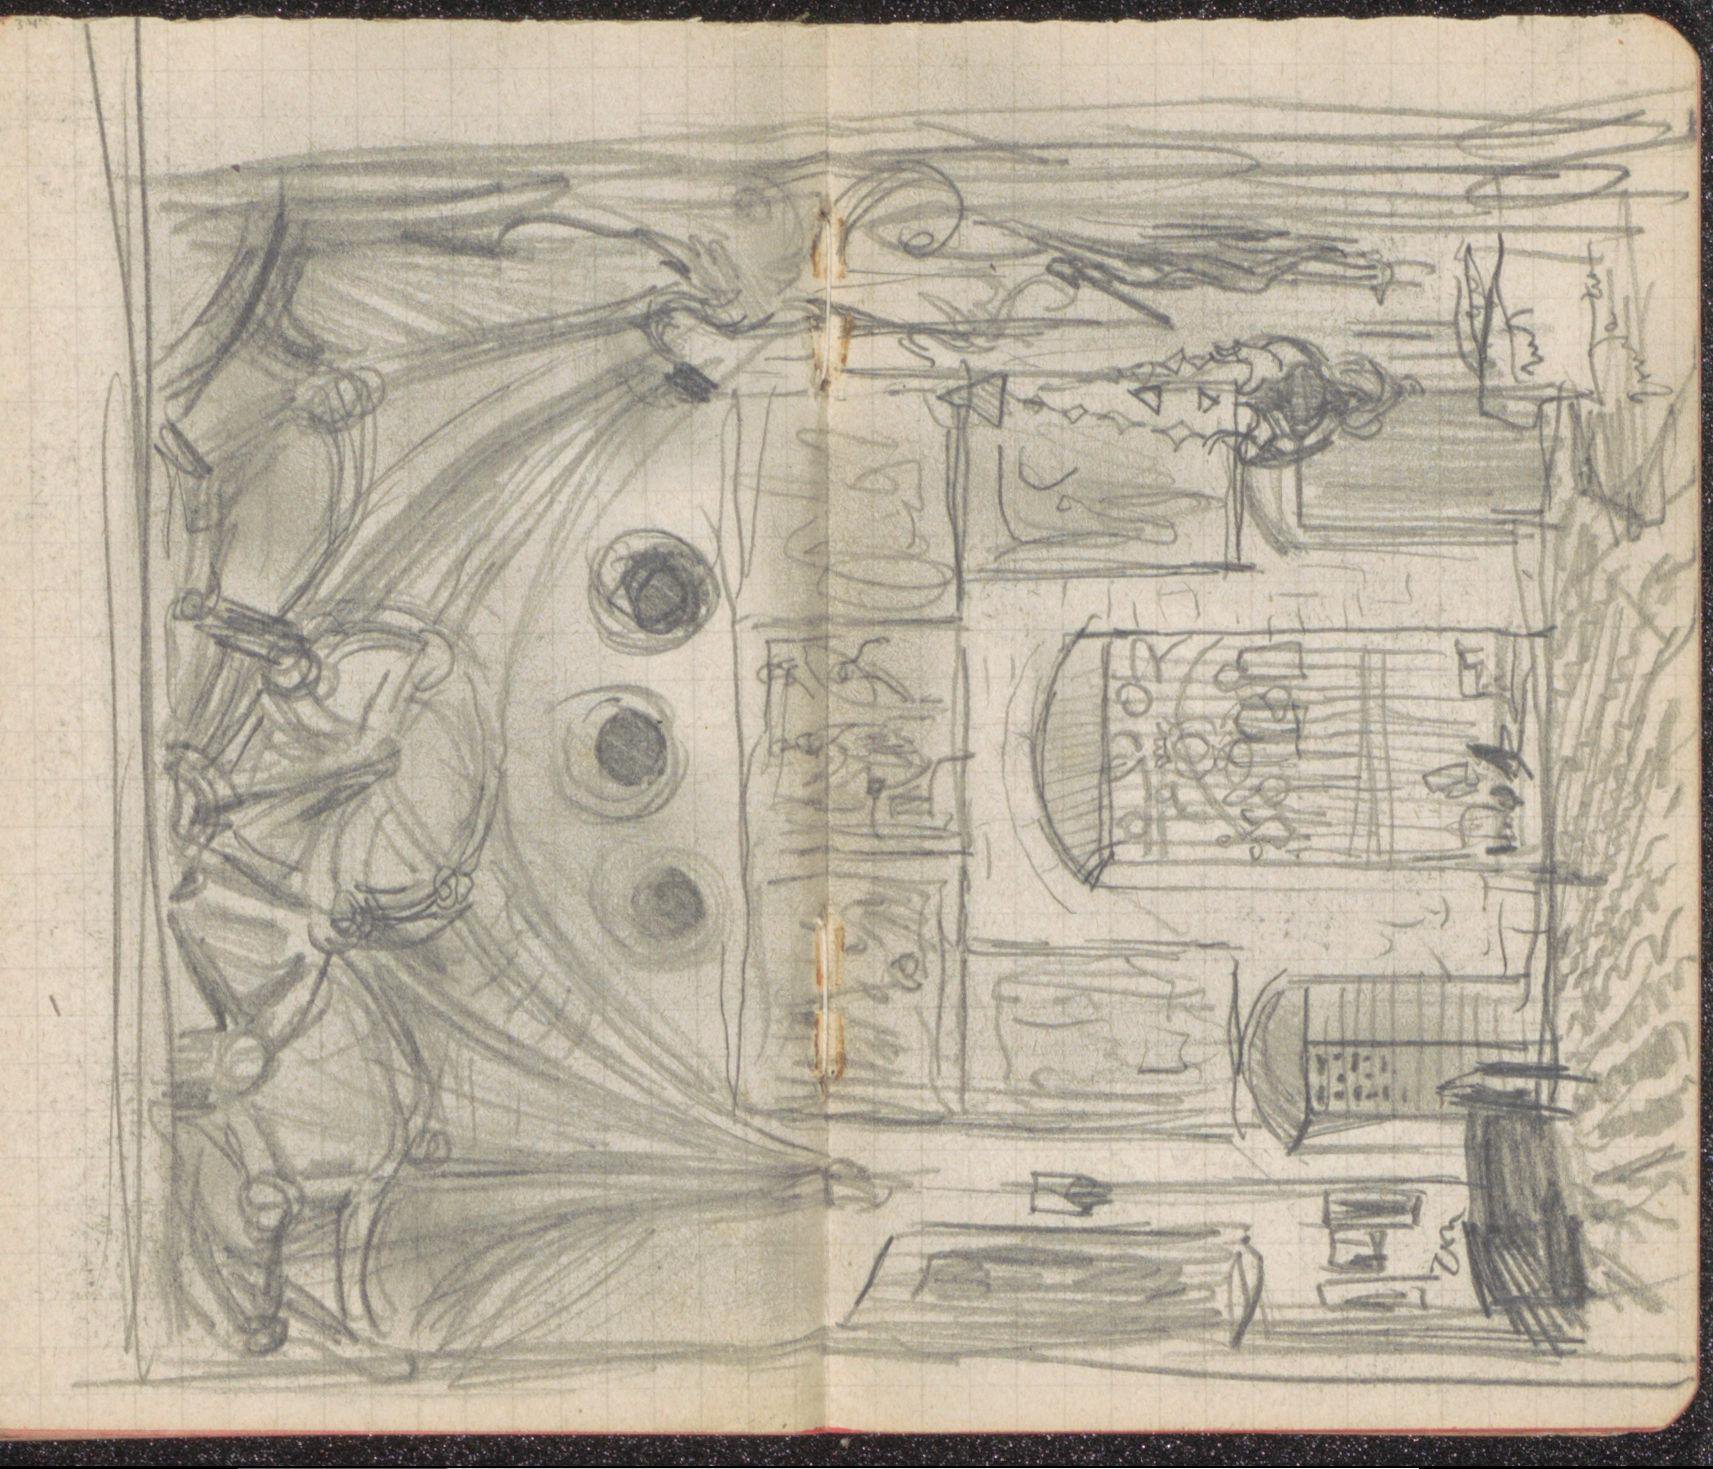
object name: sketchbook leaf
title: Kerkinterieur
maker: marius bauer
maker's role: draughtsman, print maker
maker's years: 1867-1932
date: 1902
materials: pencil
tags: censer, interior of church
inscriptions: kleurnotitie, handgeschreven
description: Rond het portaal zijn verschillende decoratieve reliëfs te zien. Op de voorgrond een wierookvat. Pagina 34 en 35 uit een schetsboek met 23 bladen.